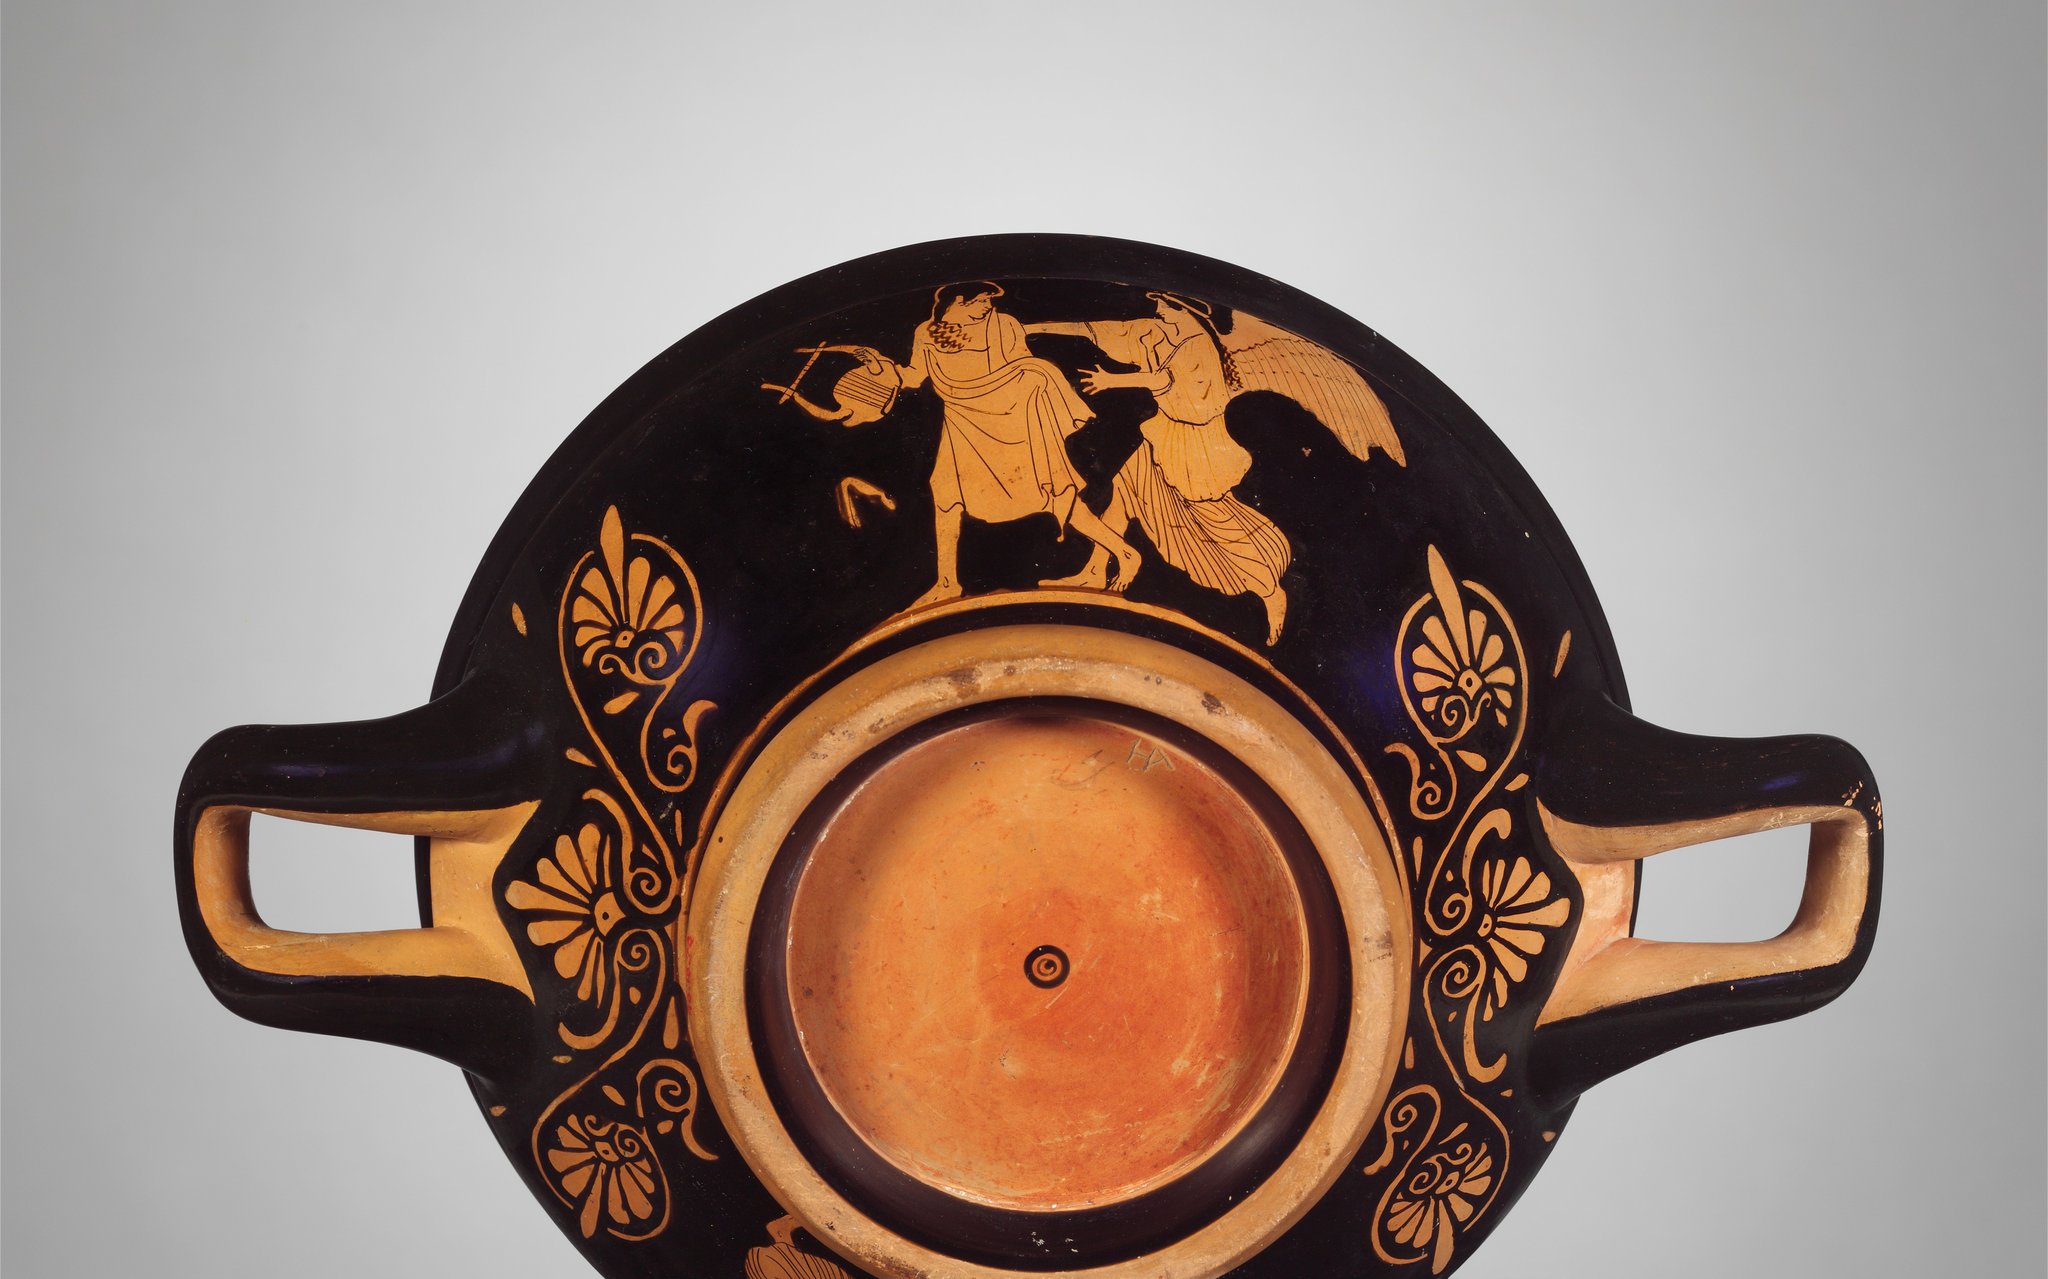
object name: kylix, stemless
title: Terracotta stemless kylix (drinking cup)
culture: greek, attic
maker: penthesilea painter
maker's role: artist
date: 460 BCE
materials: terracotta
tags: men,lyres,eos